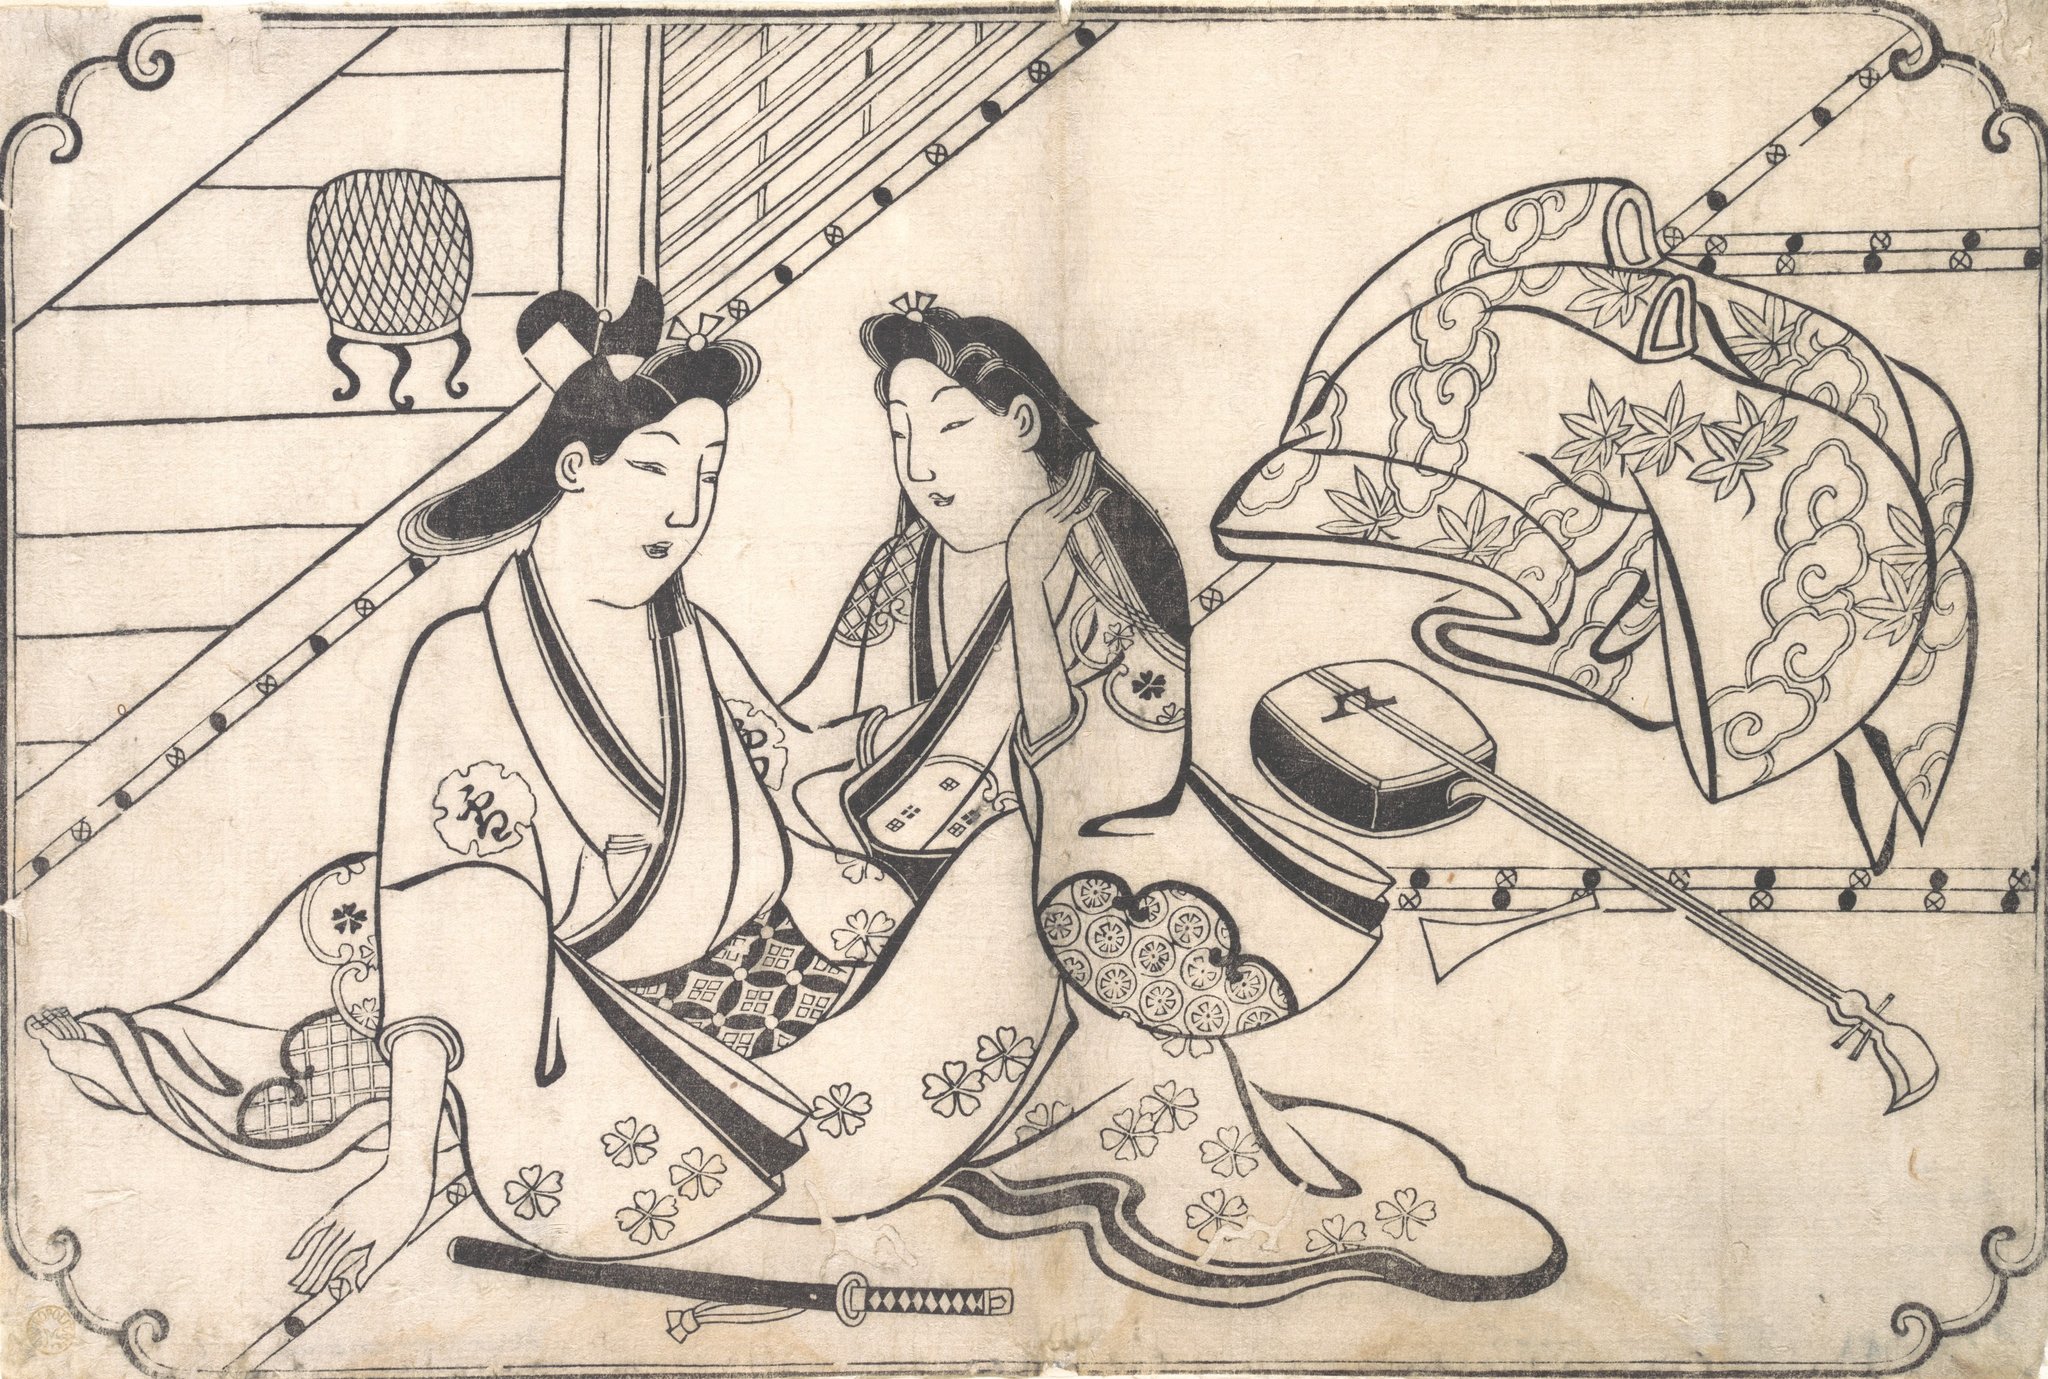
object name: print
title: Two Lovers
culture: japanese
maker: hishikawa moronobu 菱川師宣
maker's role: artist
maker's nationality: japanese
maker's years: 1618-1694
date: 1675-1680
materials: ink, paper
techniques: woodblock print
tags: musical instruments,swords,lovers,women